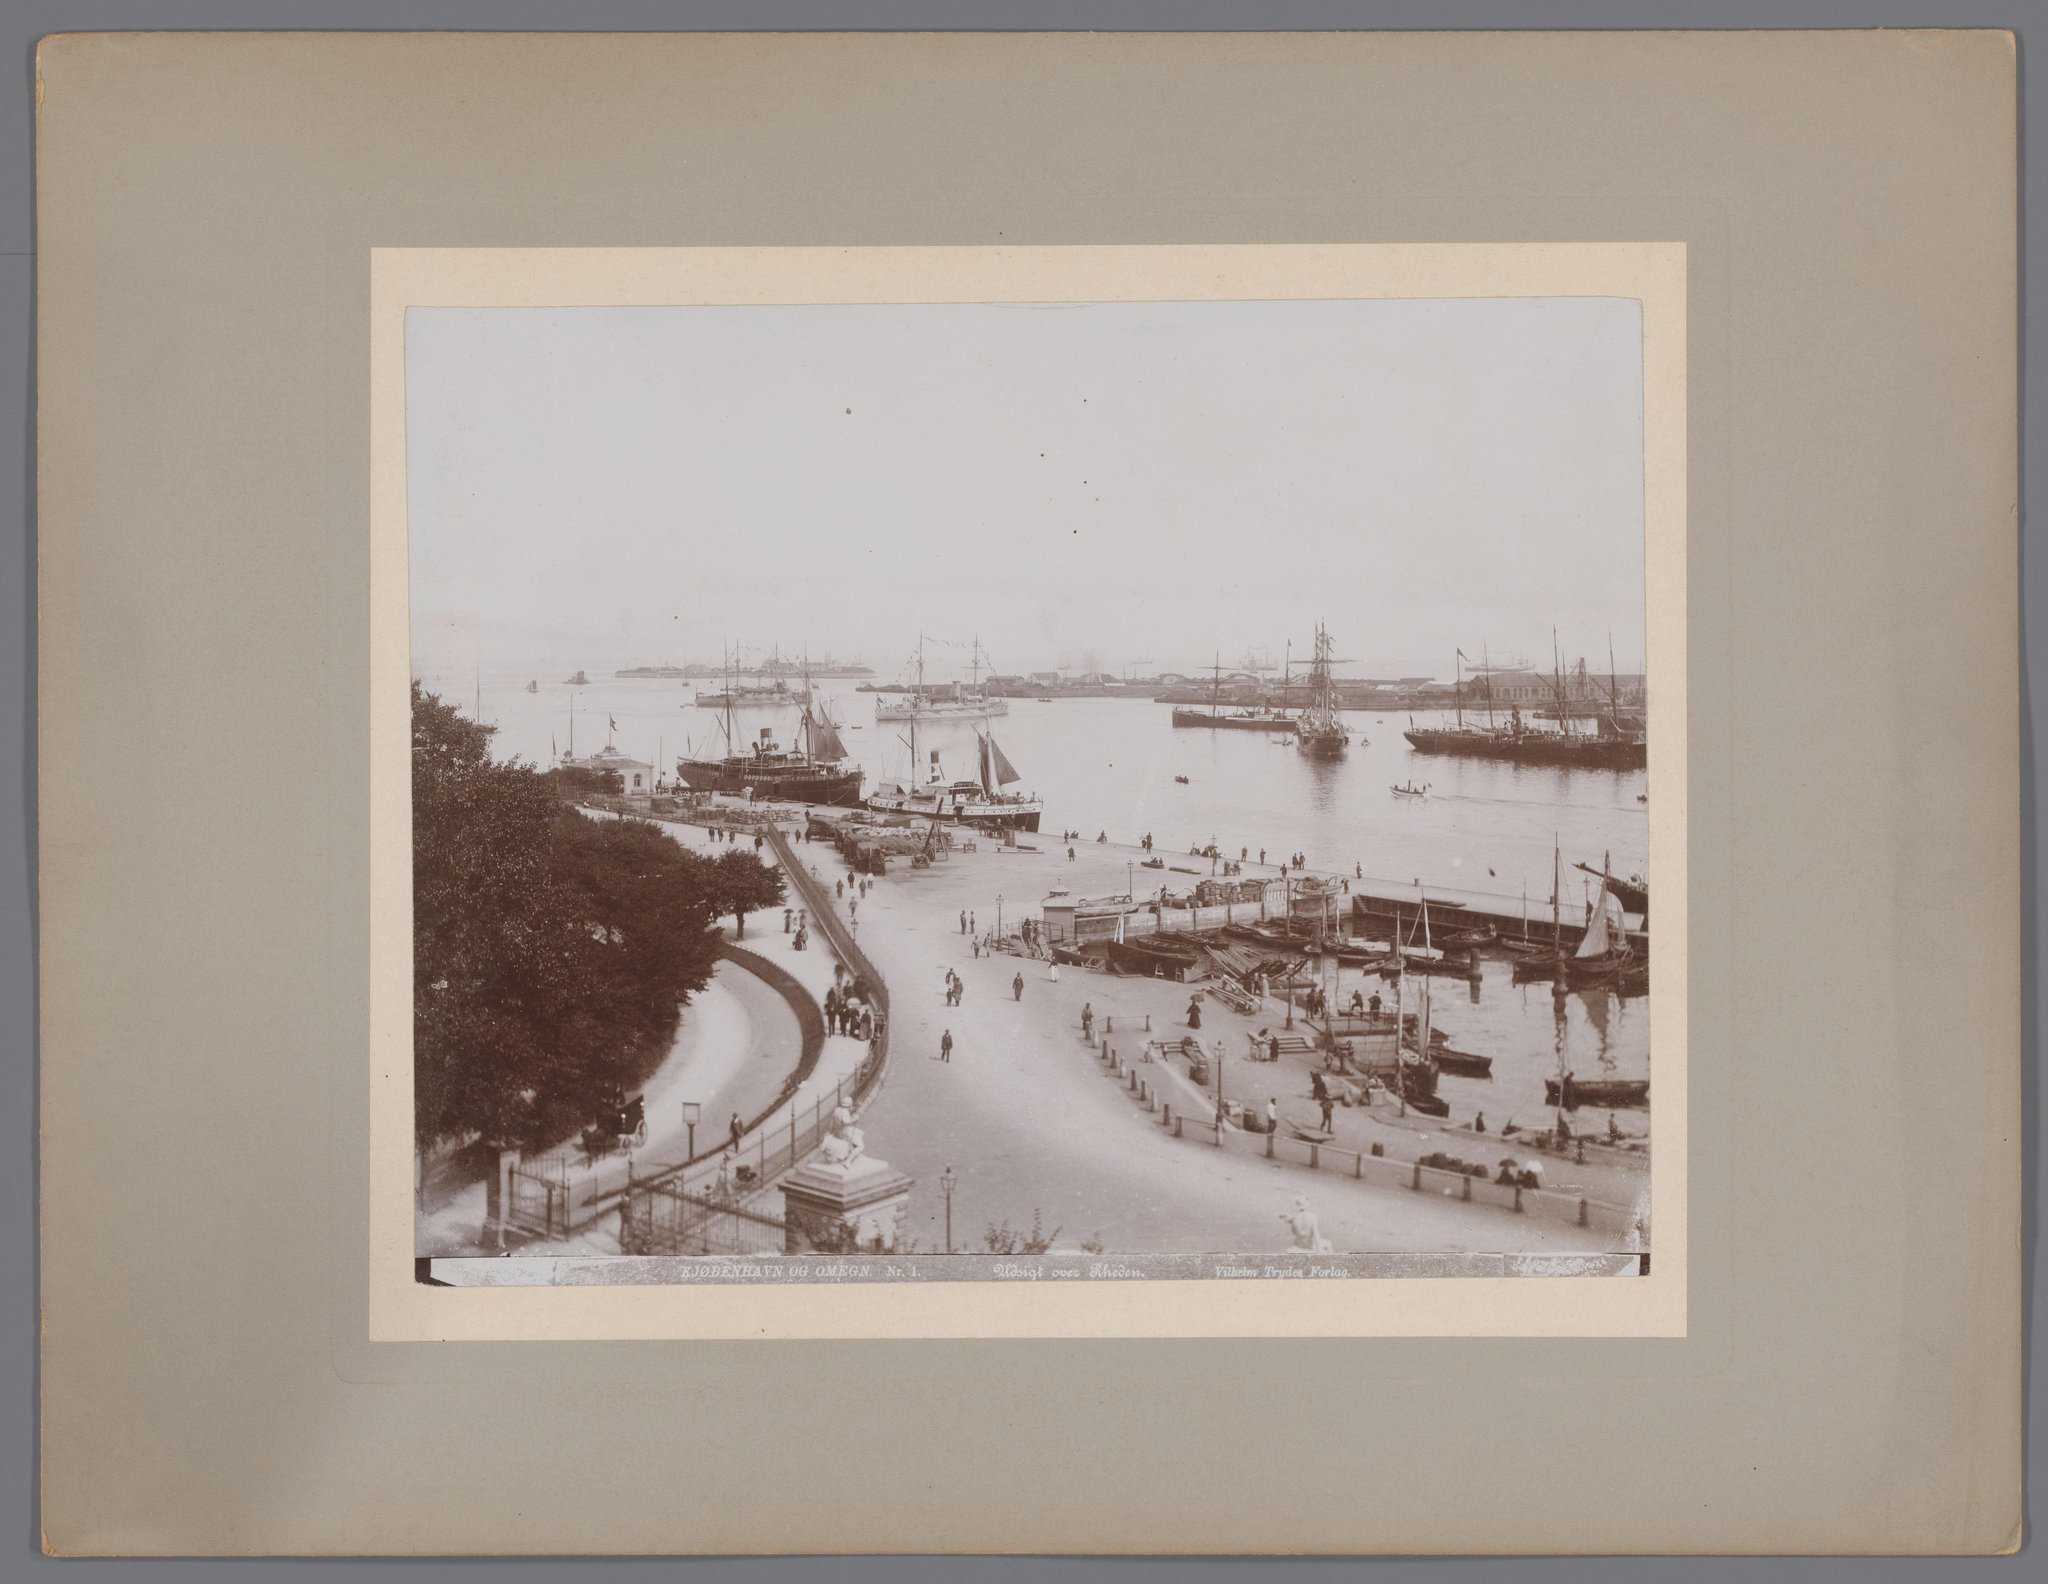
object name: photograph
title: Kjøbenhavn og Omegn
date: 1880-1910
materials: paper, cardboard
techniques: collodion silver print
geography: copenhagen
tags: harbour, copenhagen (city)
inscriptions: number: ‘Nr. 1.’